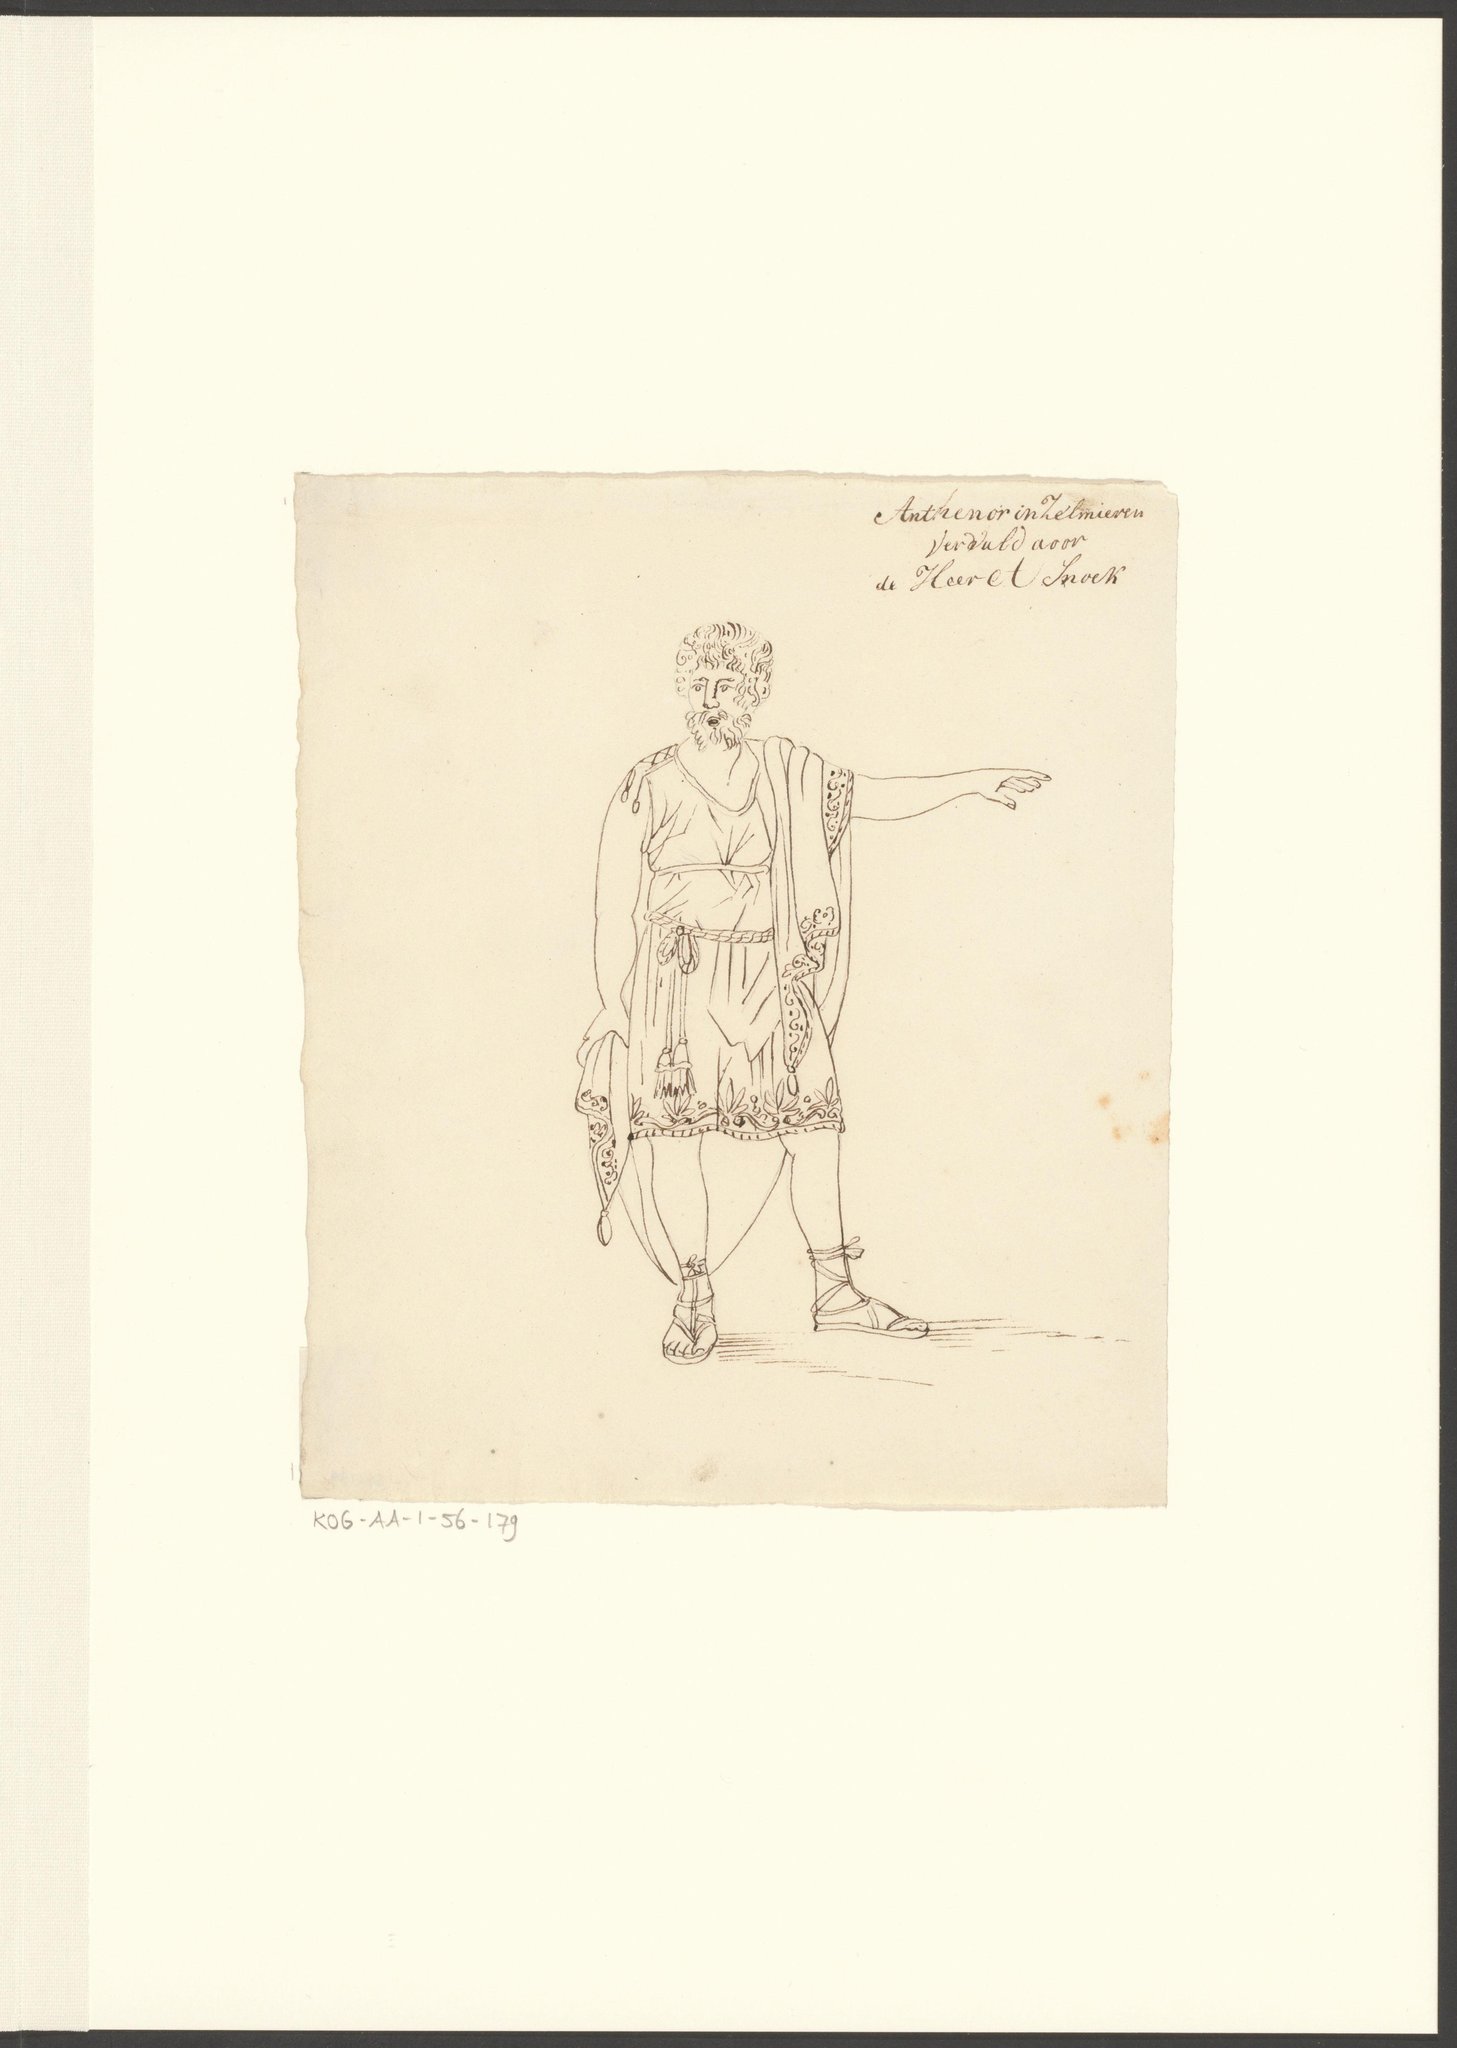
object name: drawing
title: Portret van toneelspeler Andreas Snoek in de rol van Anthenor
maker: johannes jelgerhuis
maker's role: draughtsman, painter, print maker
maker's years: 1770-1836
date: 1791-1829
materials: ink, paper, pencil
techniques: pen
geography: amsterdam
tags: historical persons, portrait of actor, actress, actor (on the stage), amsterdam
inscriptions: inscription: ‘Anthenor in Zelmieren / VerVuld door / de Heer A Snoek’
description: Voorbereidende tekening op de prentserie Acteurs en actrices in verschillende rollen van Johannes Jelgerhuis.